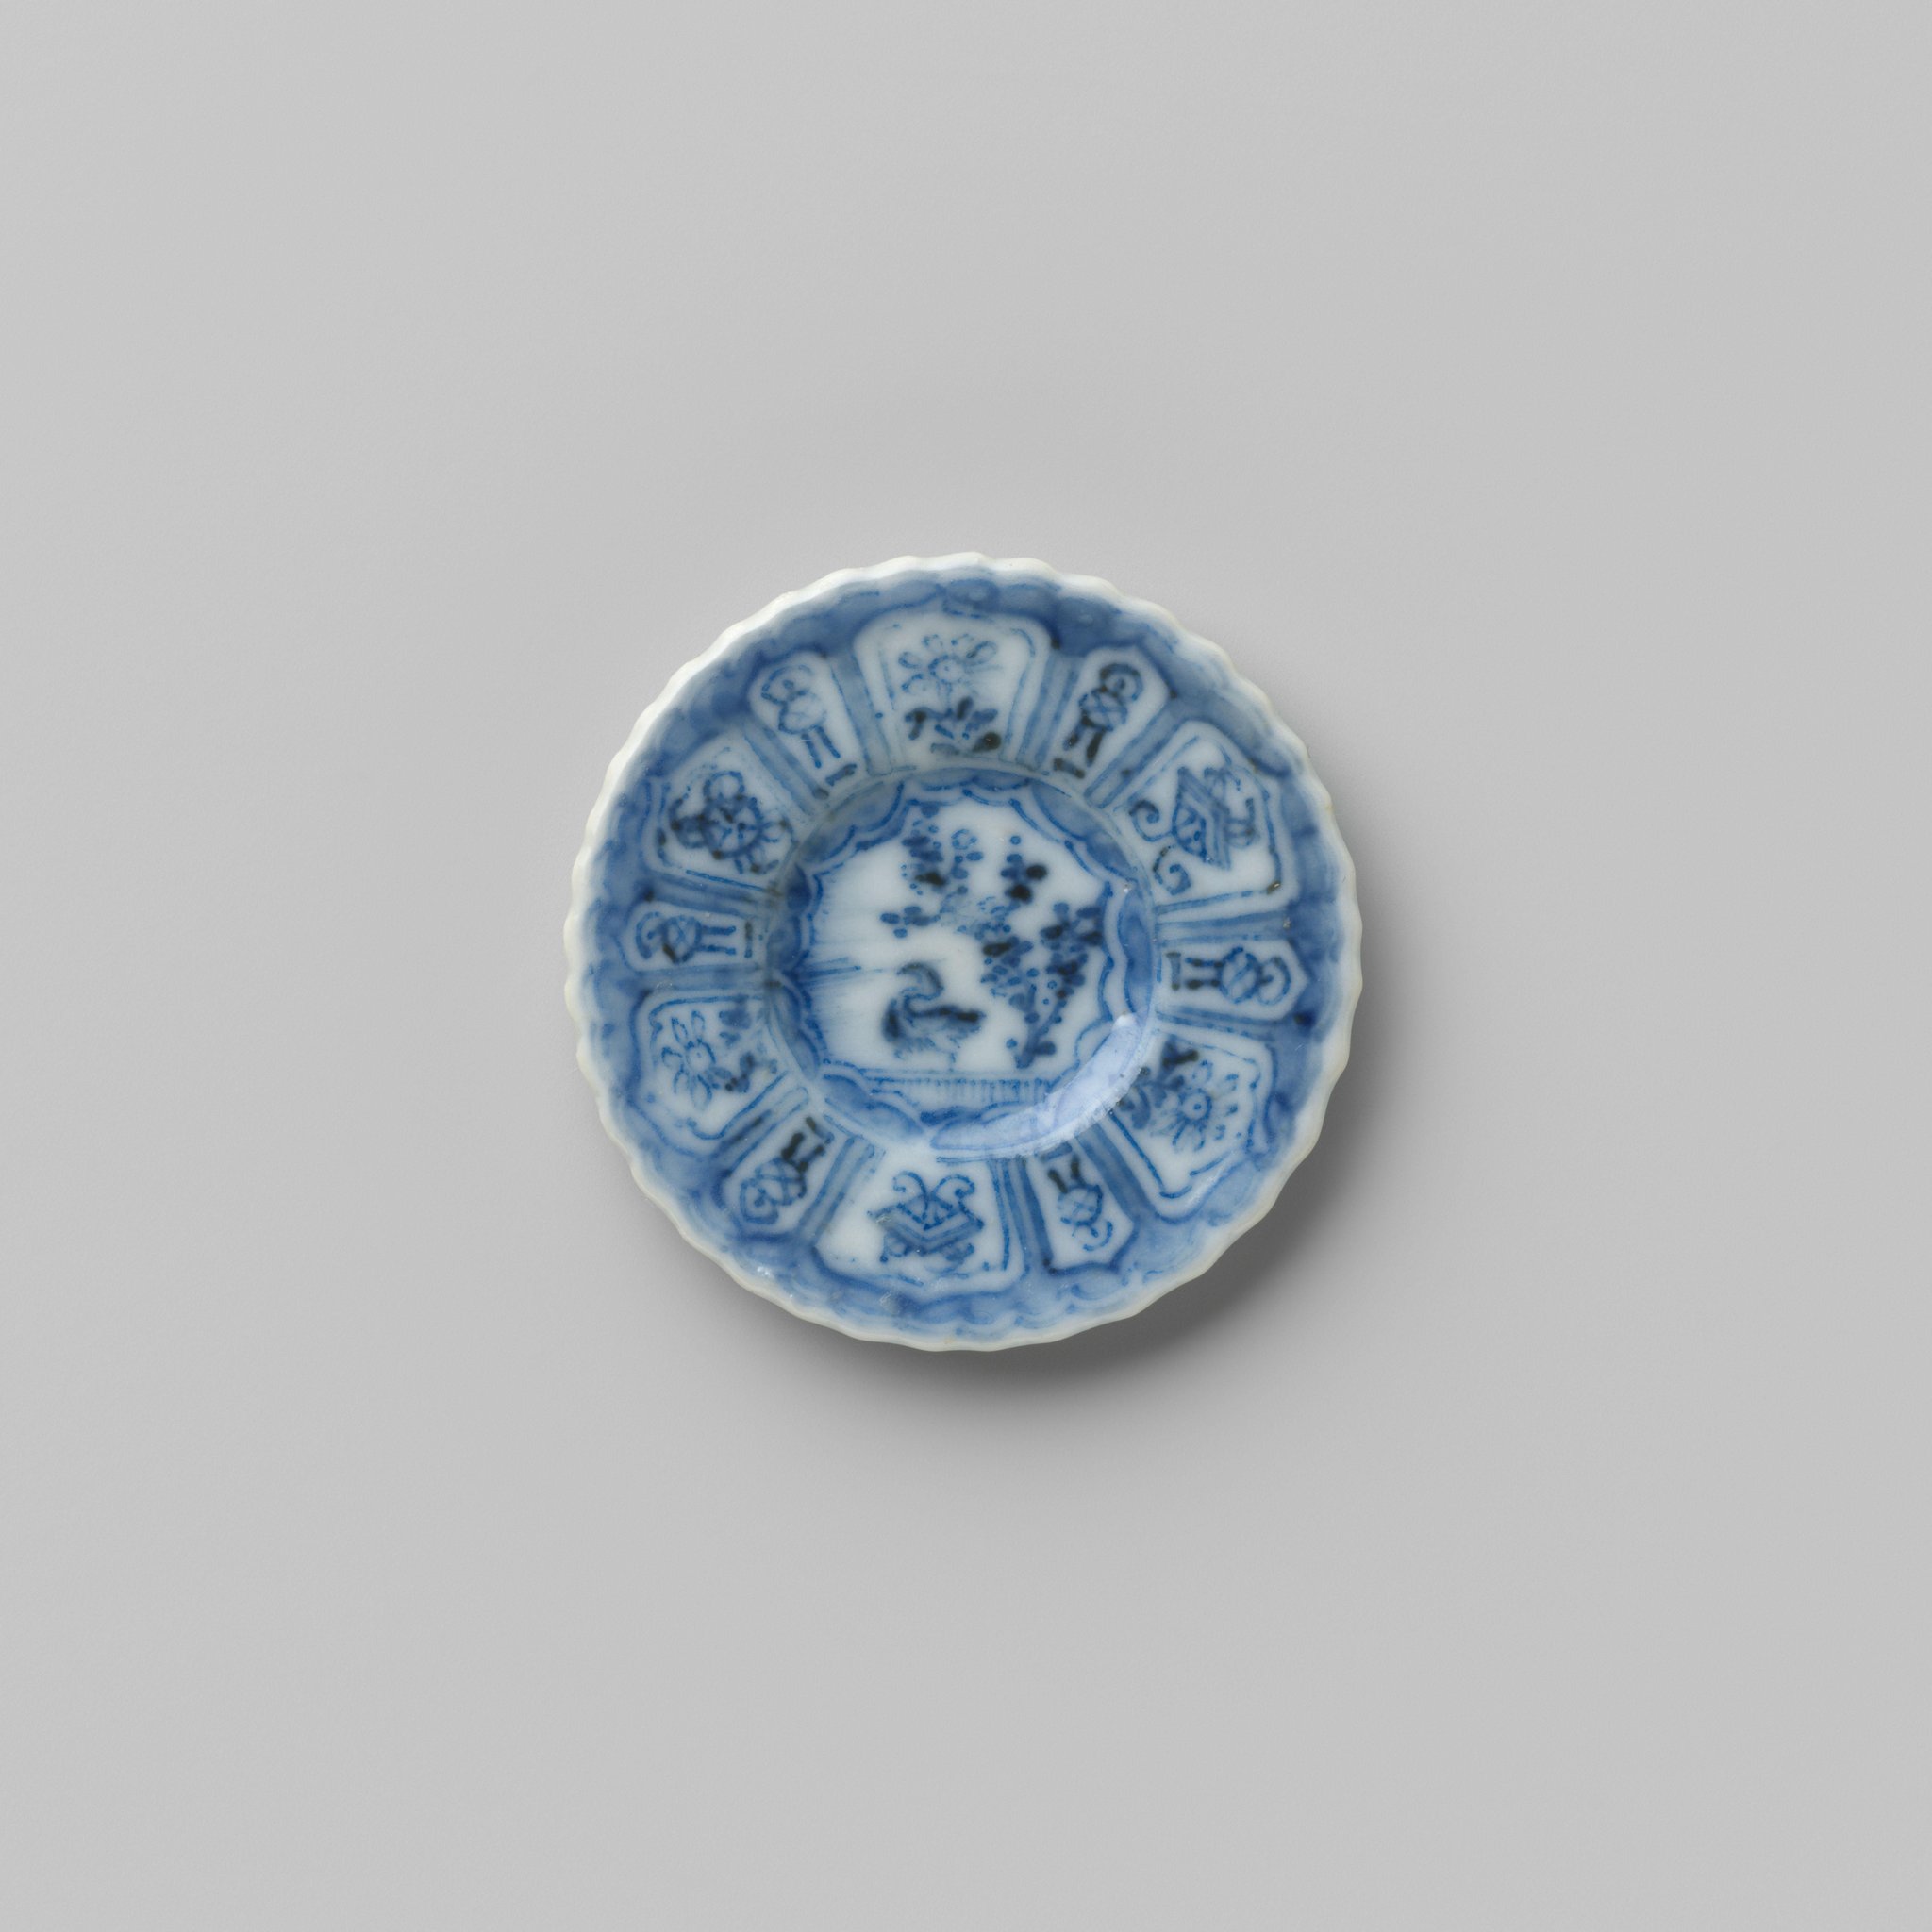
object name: plate dish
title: Plate with a bird in a landscape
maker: Anonymous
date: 1690-1710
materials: cobalt, glaze, paint, porcelain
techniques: firing, turning, vitrification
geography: china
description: Eén van 12 borden van porselein en steatite met blauwe onderglazuur, decoratie in 'Kraakporselein' of Wanli stijl: plat met vogel (eend) onder boom aan oever, rand in vakken met strikwerk, bloemen en symbolen, geribbelde rand. Bordje eveneens op achterzijde versierd, rand in vakken met bloemen.